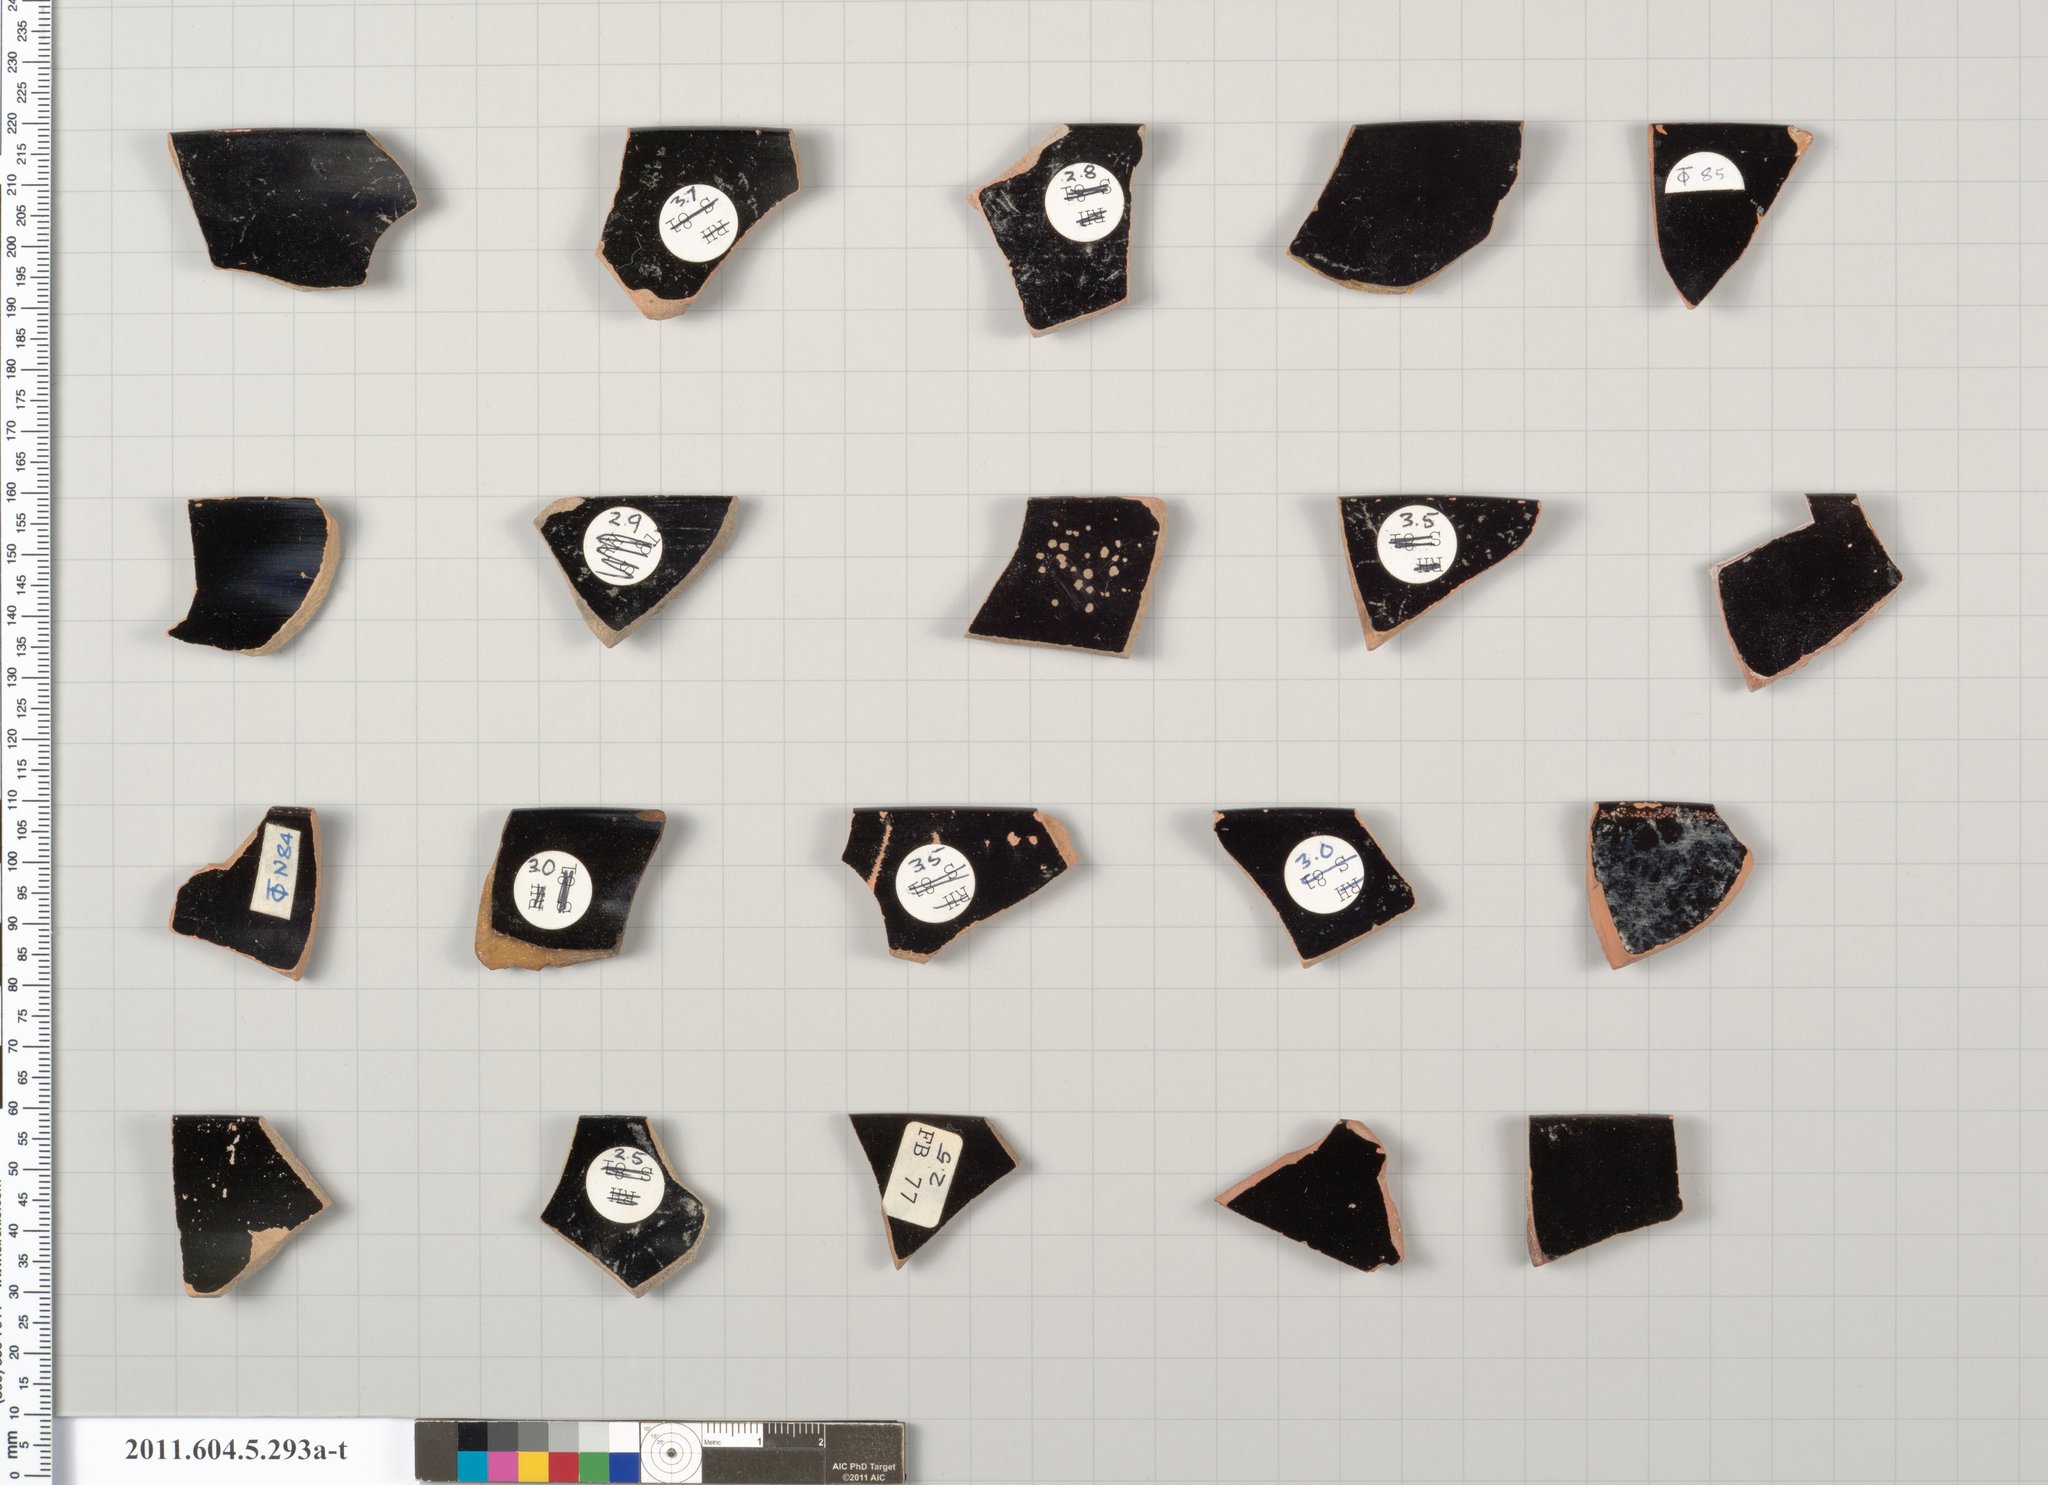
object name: kylix fragment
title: Terracotta rim fragments of kylikes (drinking cups)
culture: greek, attic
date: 600-401 BCE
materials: terracotta